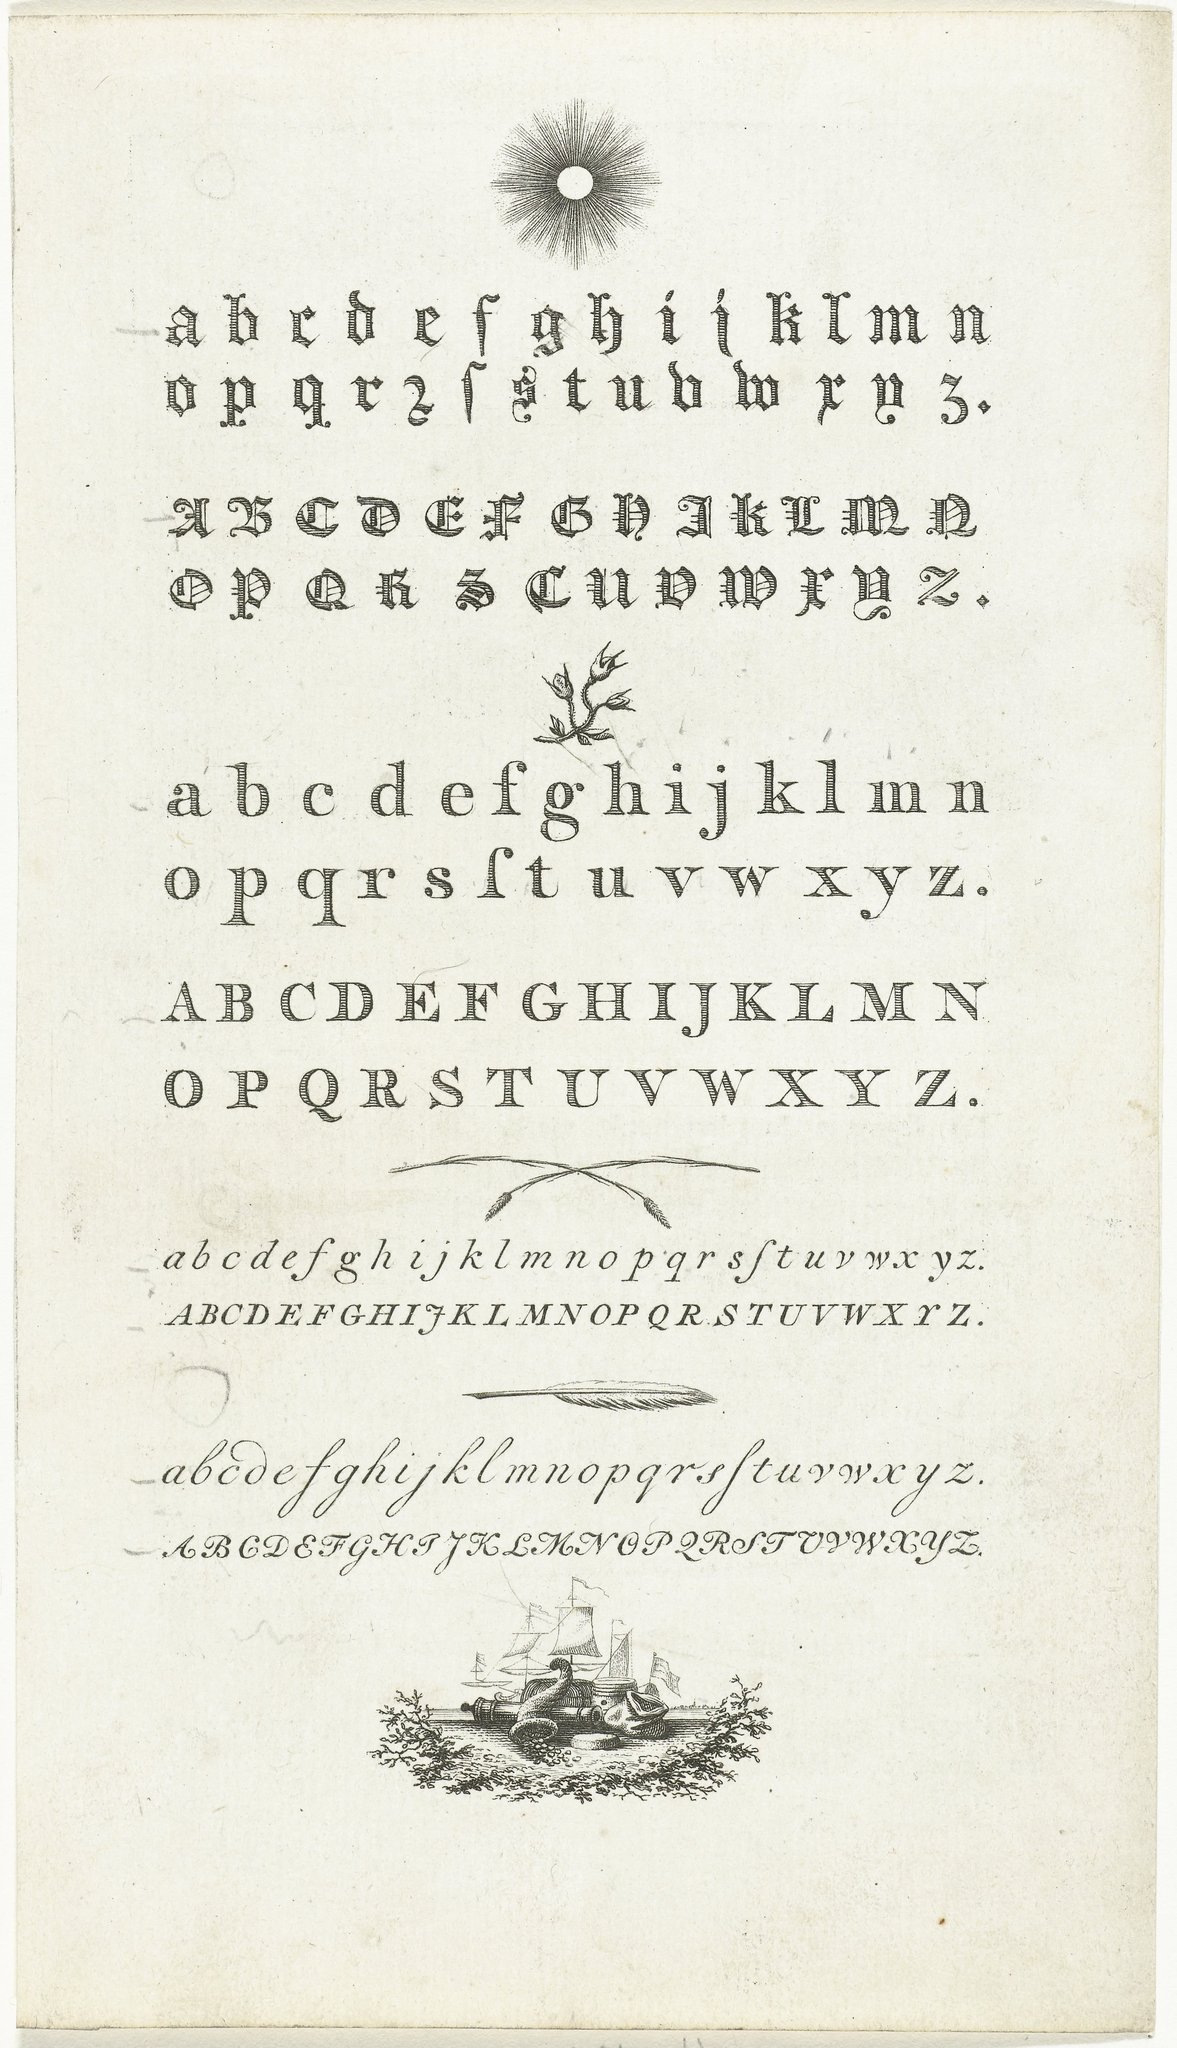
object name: book illustration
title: Alfabetten in verschillende lettertypes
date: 1781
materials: paper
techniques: etching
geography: amsterdam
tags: letters, alphabet, script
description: Illustratie voor het 'Vaderlandsch A-B boek, voor de Nederlandsche jeugd' door J.H. Swilden. Acht alfabetten in verschillende lettertypes. Onder een vignet met een schip en kruitvaten.